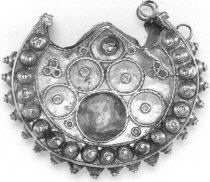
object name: earring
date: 1001-1300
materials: gold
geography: iran